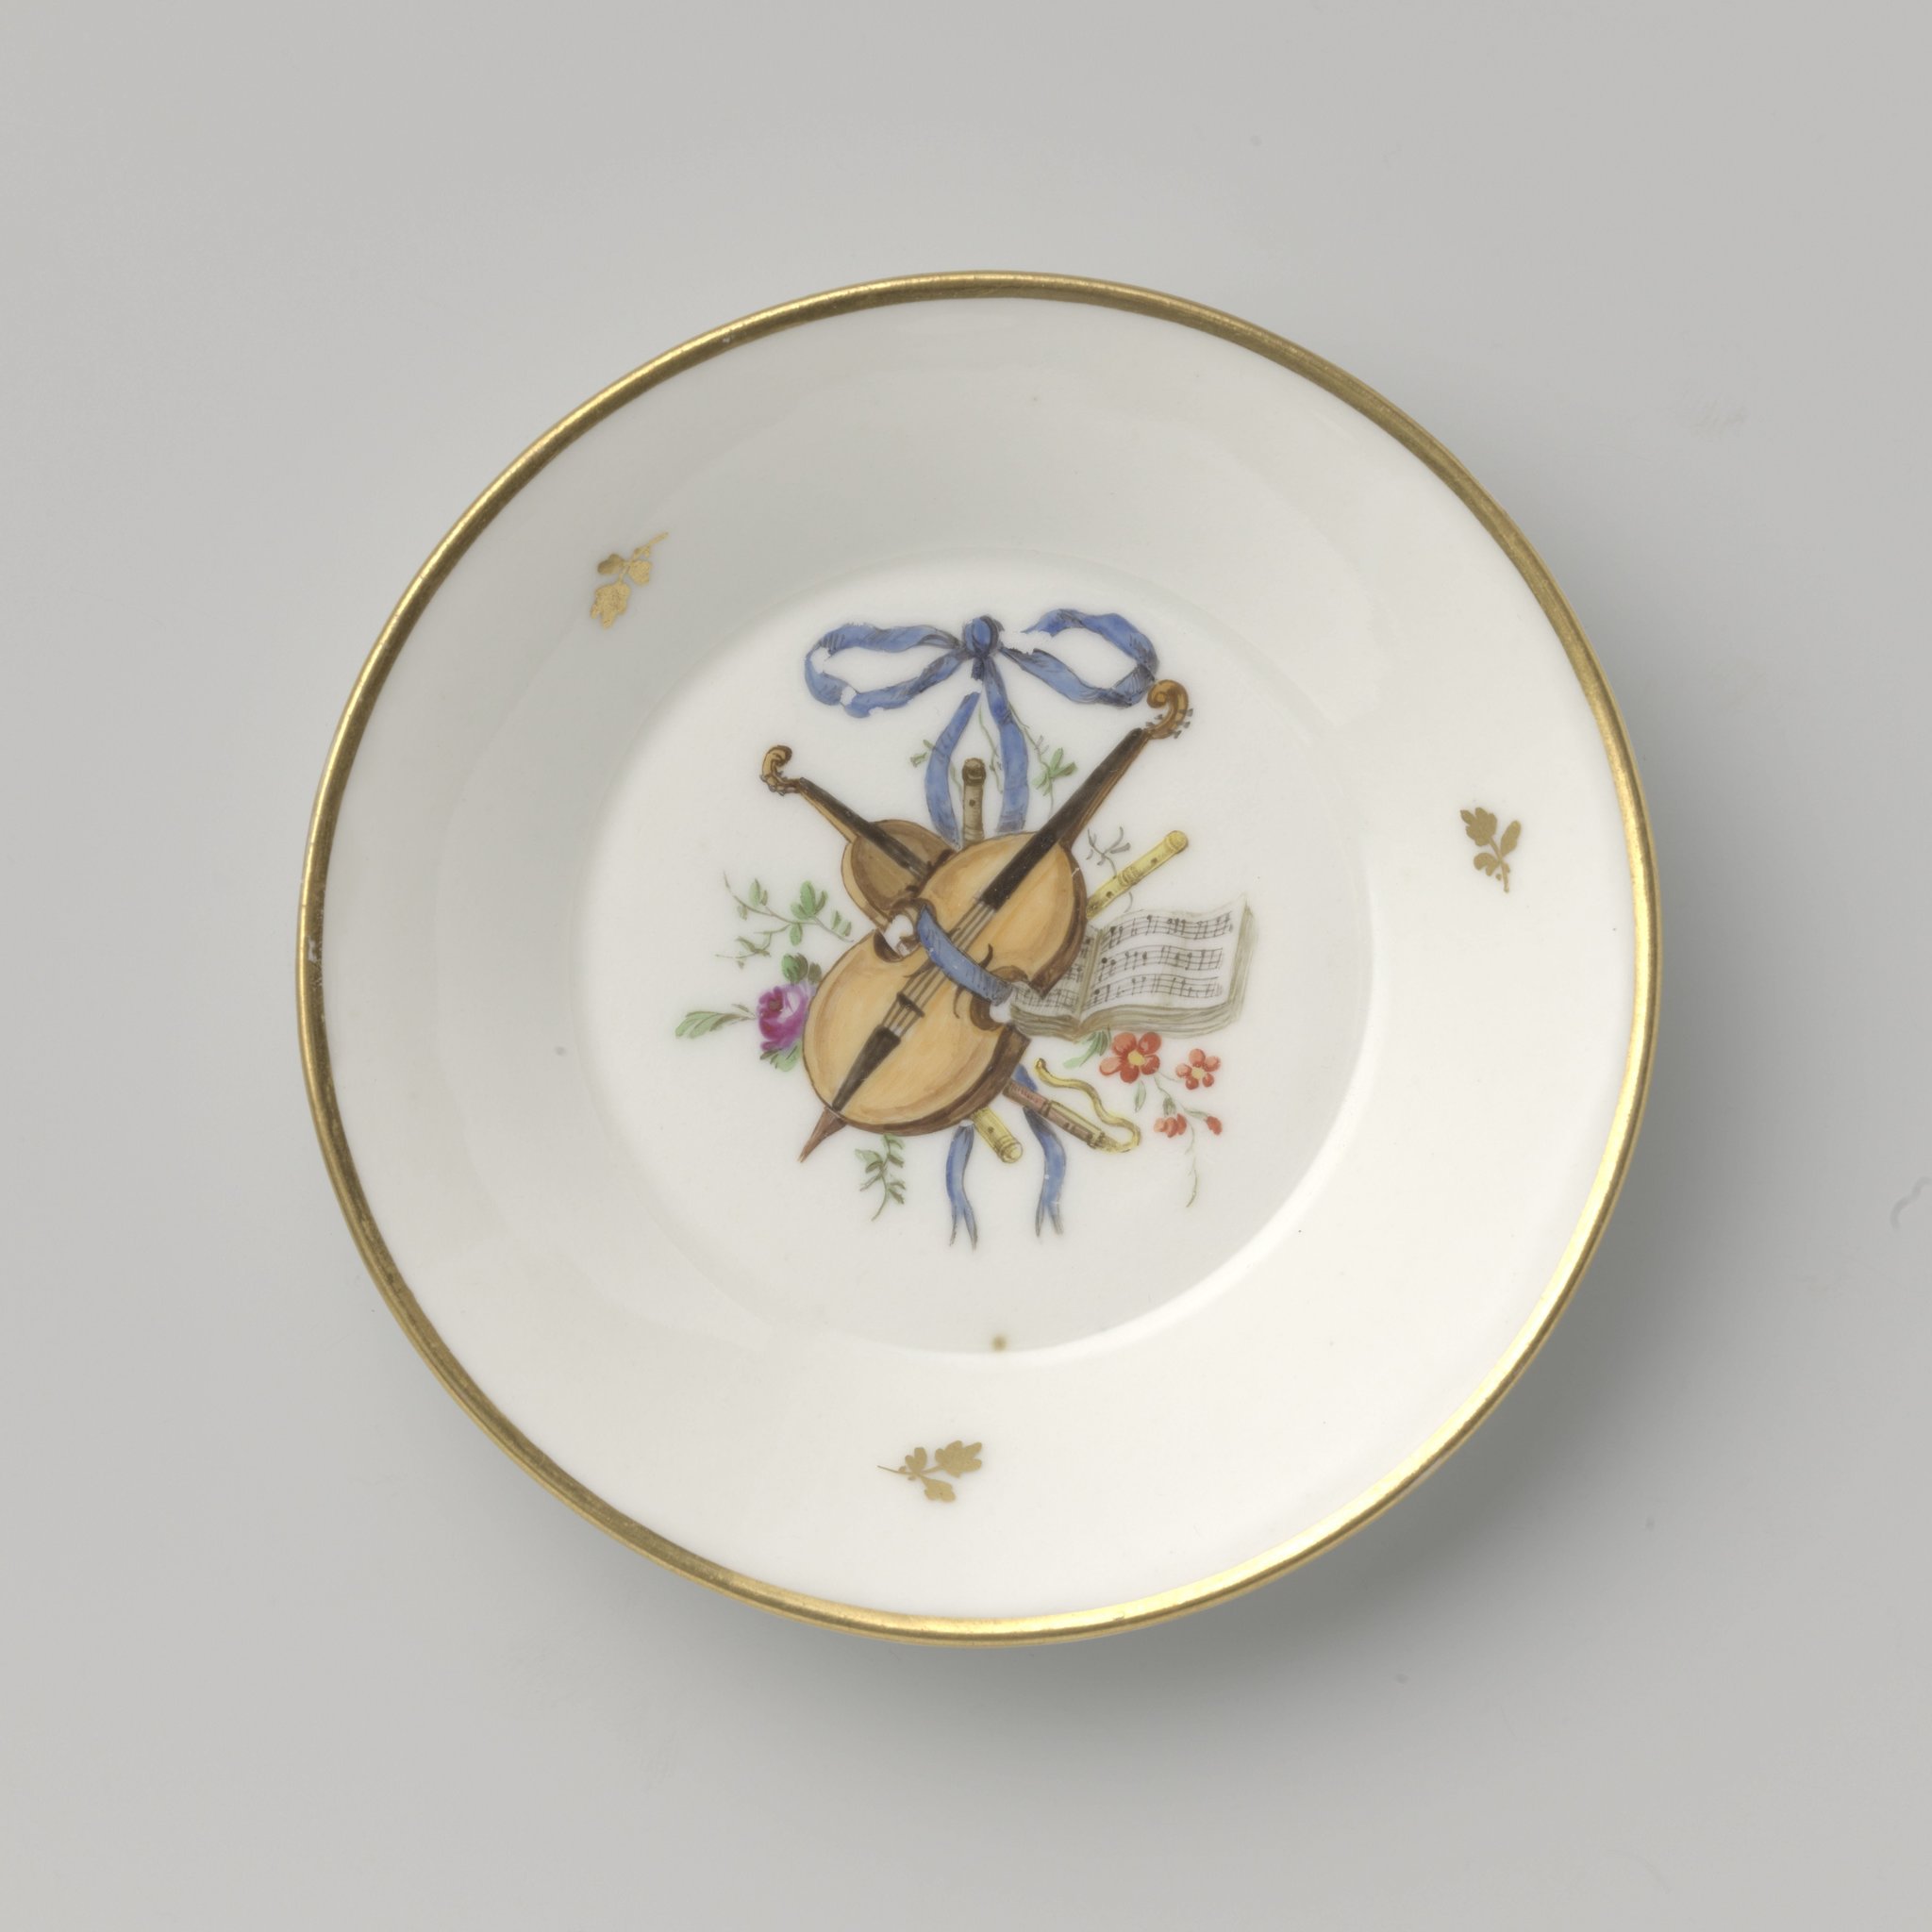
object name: platter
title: Schotel behorend bij een theeservies met decoratie van trofeeën aan gestrikte linten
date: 1809-1814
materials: porcelain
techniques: painted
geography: nieuwer-amstel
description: Theeservies bestaande uit een theepot, een suikerpot, een spoelkom en twaalf koppen en schotels veelkleurig beschilderd met trofeeën hangend aan blauwe strikken. De trofeeën hebben betrekking op diverse beroepen. Gemerkt in zwart: Amstel (de suikerpot Amstel N. 805 en ingegrift A). Verschillende ingegrifte merken in de koppen en schotels.